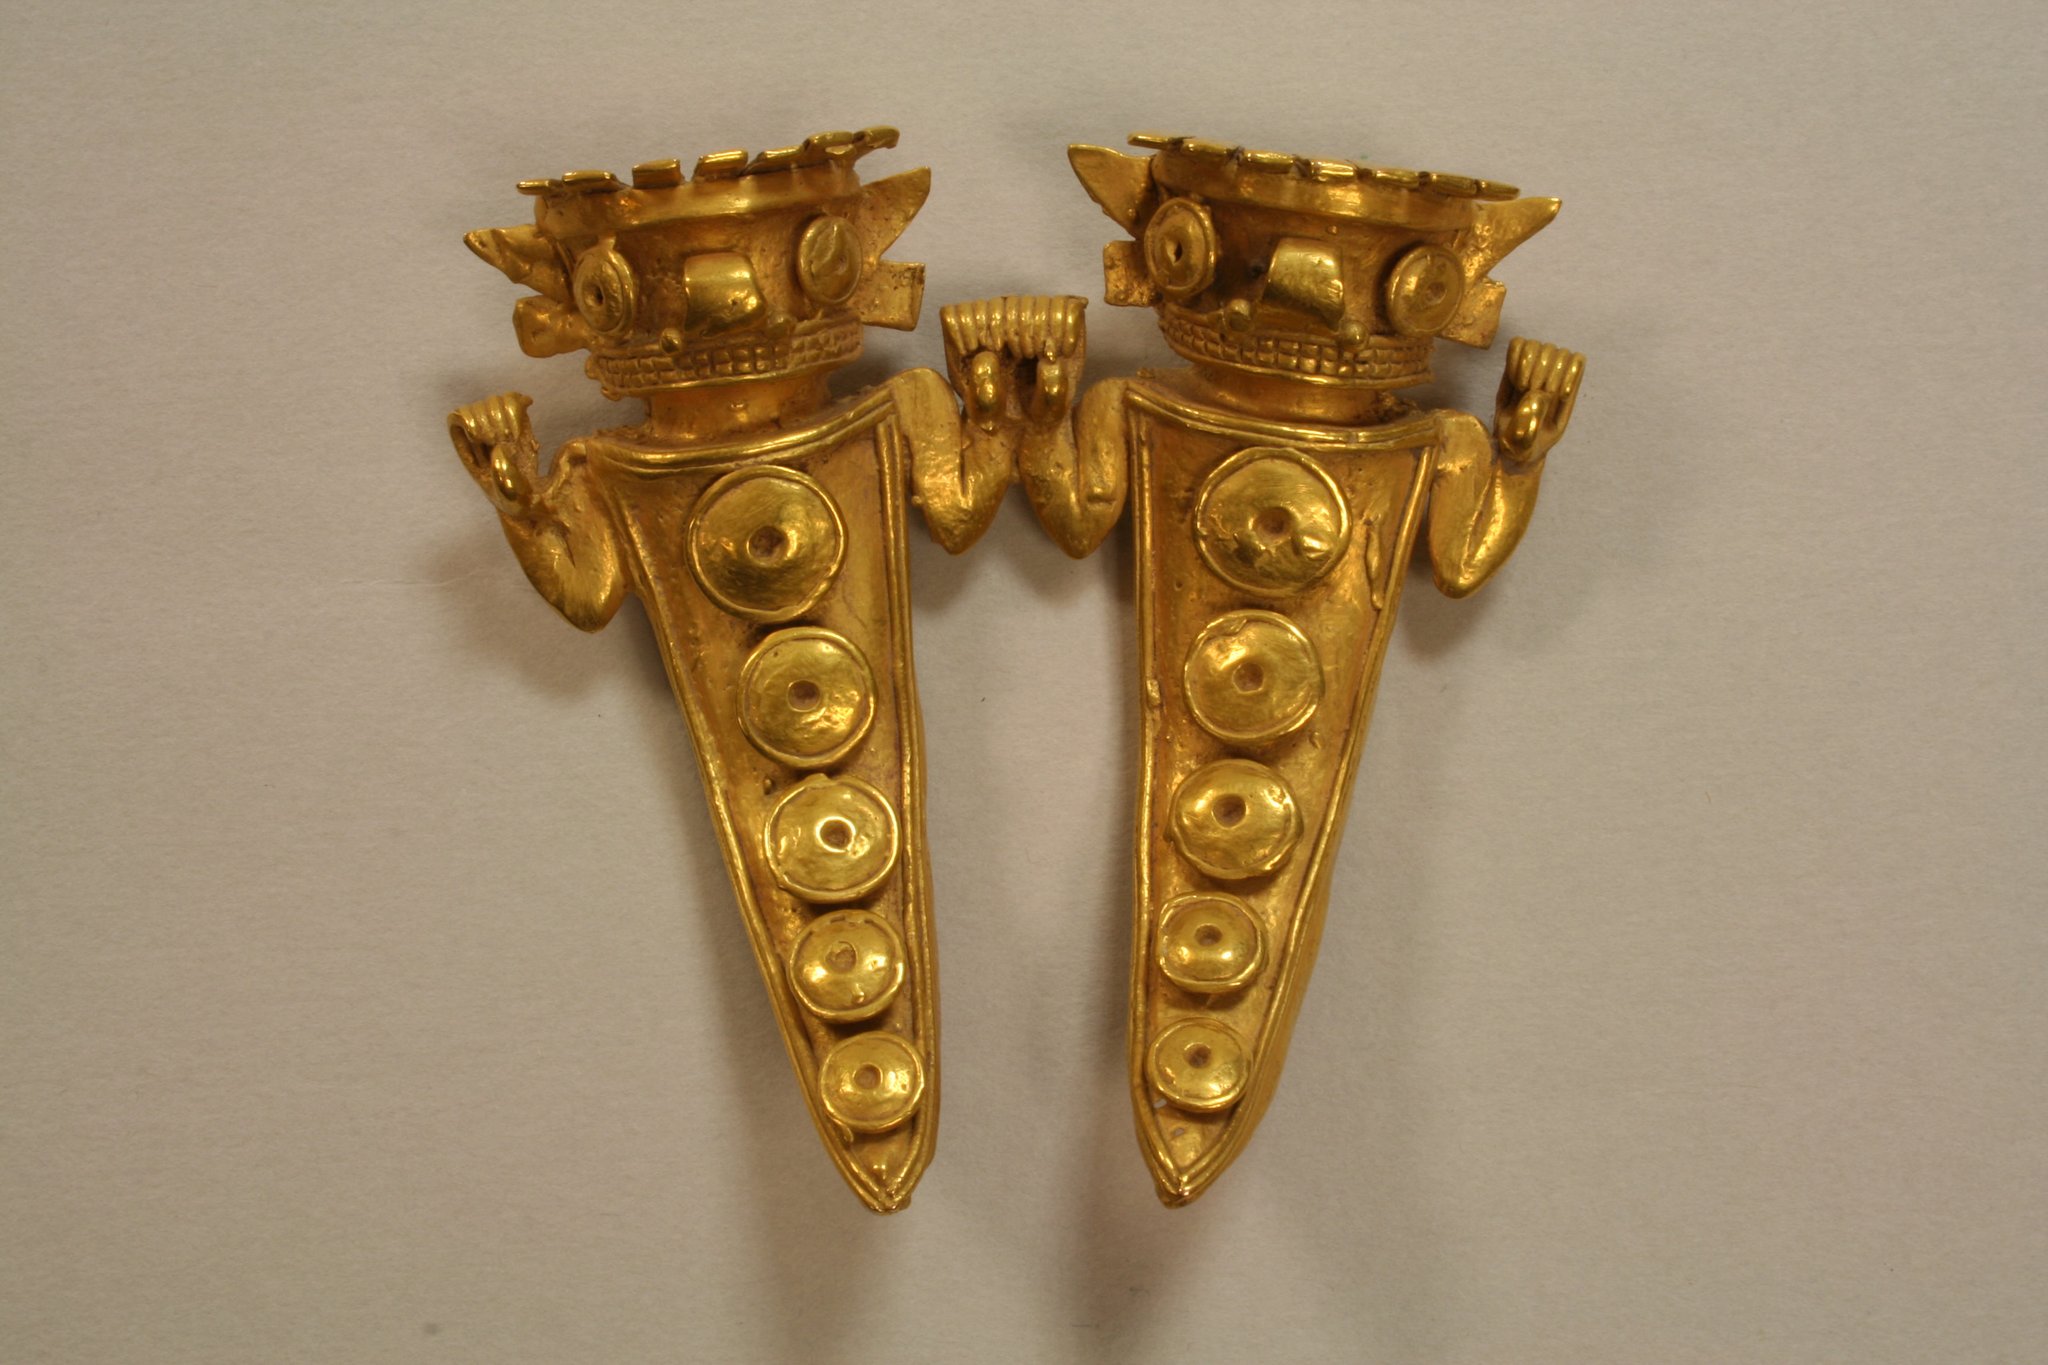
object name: pendant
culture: panamanian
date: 701-1100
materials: gold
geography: panama